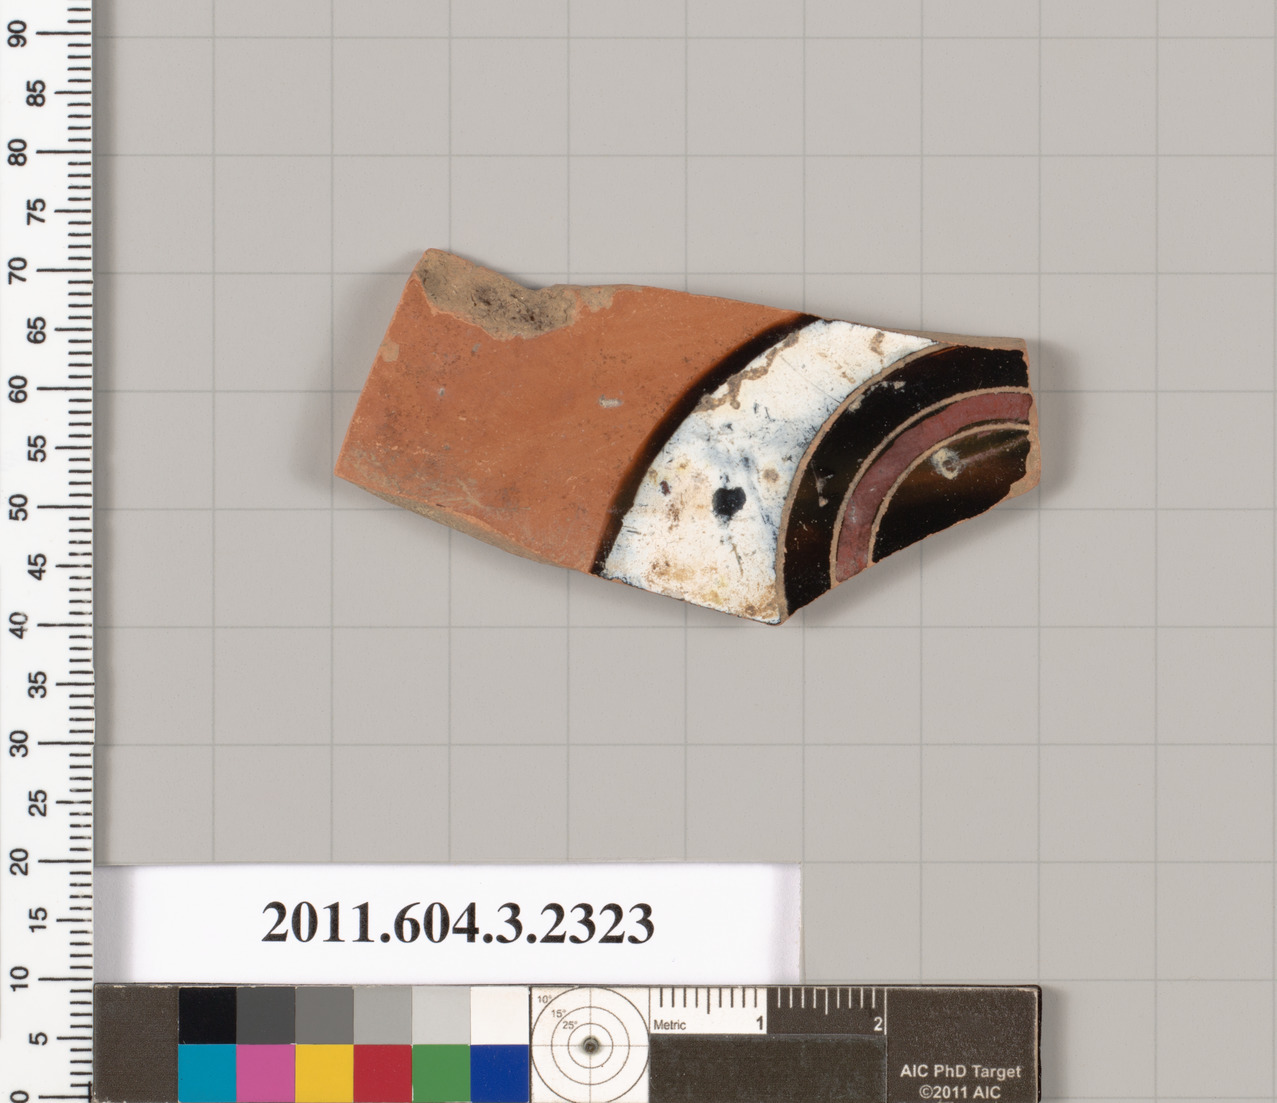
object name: kylix fragment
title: Terracotta fragment of a kylix: eye-cup (drinking cup)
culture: greek, attic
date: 540-520 BCE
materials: terracotta